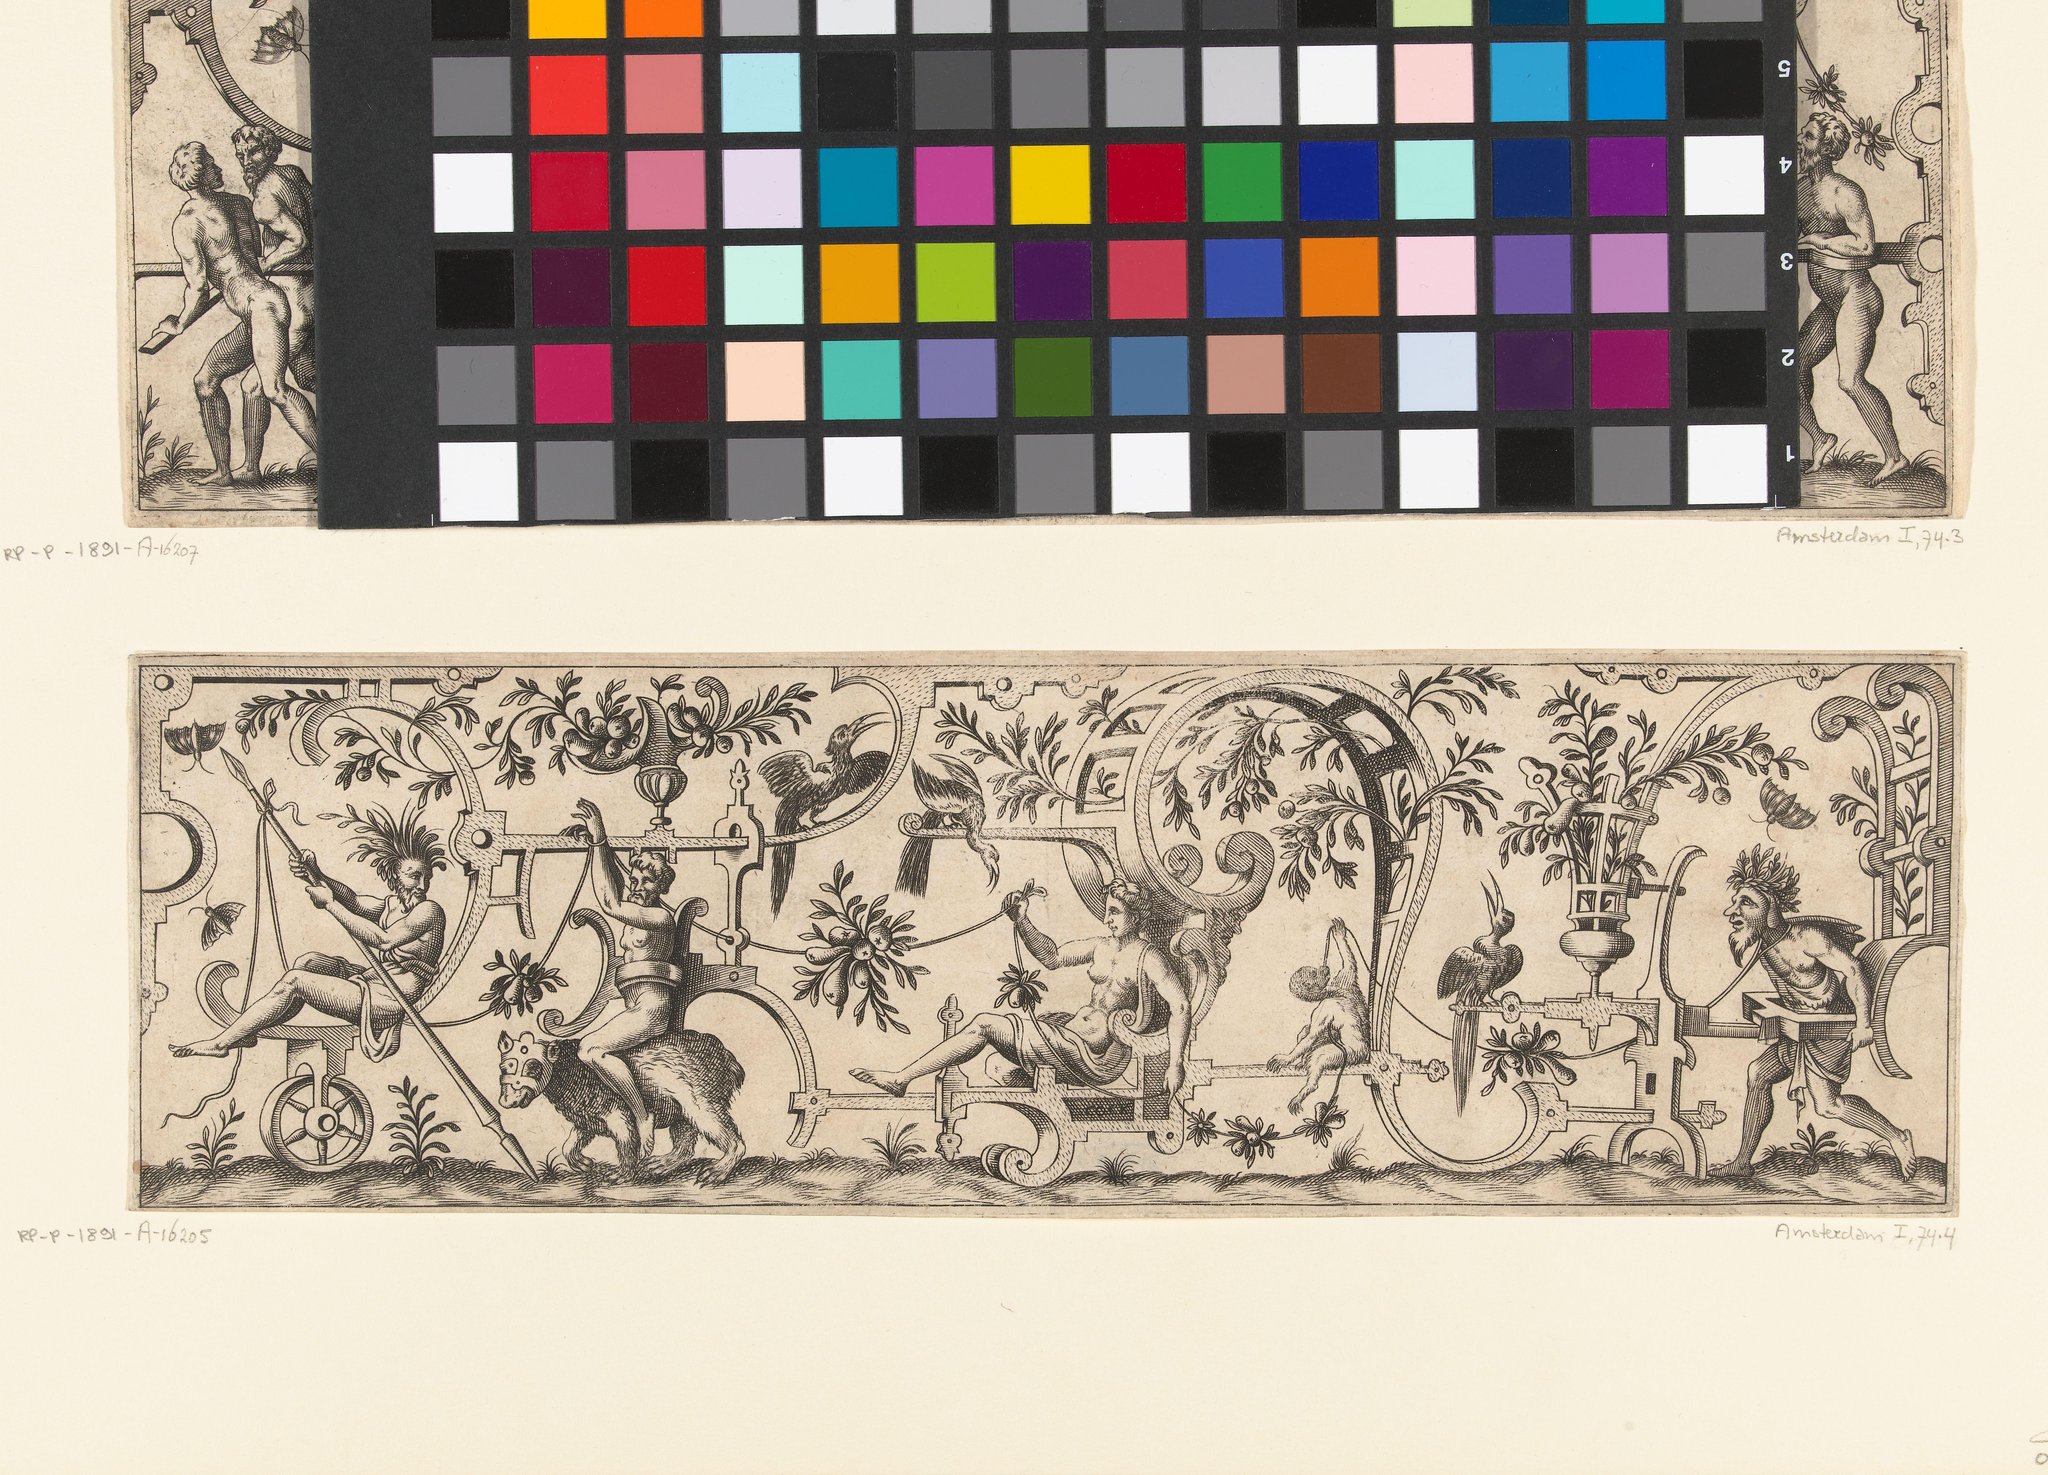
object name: print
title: Wagen met een vrouw, geduwd door een man en getrokken door een man die op de rug van een beer rijdt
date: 1552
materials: paper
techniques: etching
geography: netherlands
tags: ornament ~ grotesque, chariot, triumphal car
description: Voorop zit een man met een lans. Achter de rug van de vrouw zit een aapje. Hoort bij serie van 4 bladen.